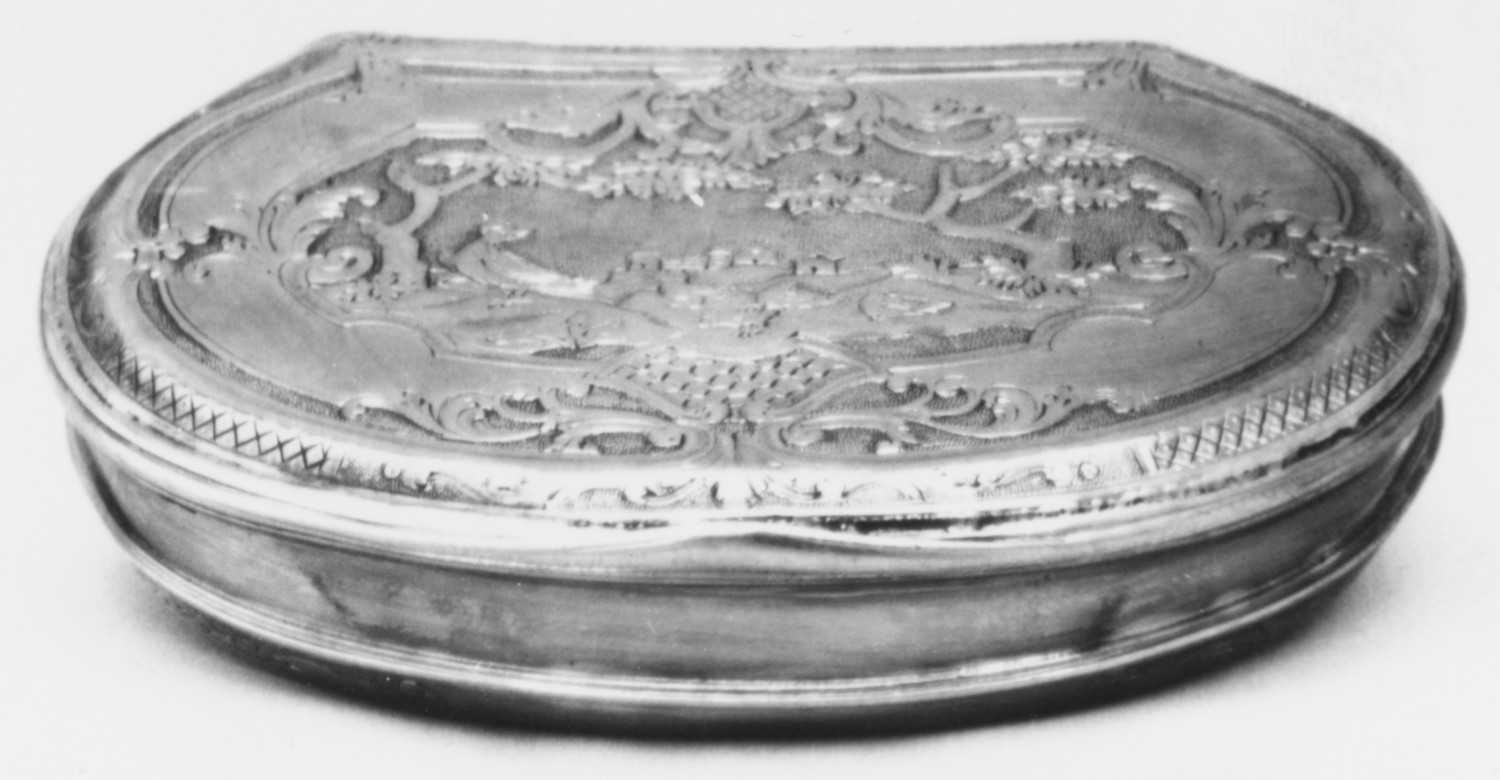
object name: box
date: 1735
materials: silver